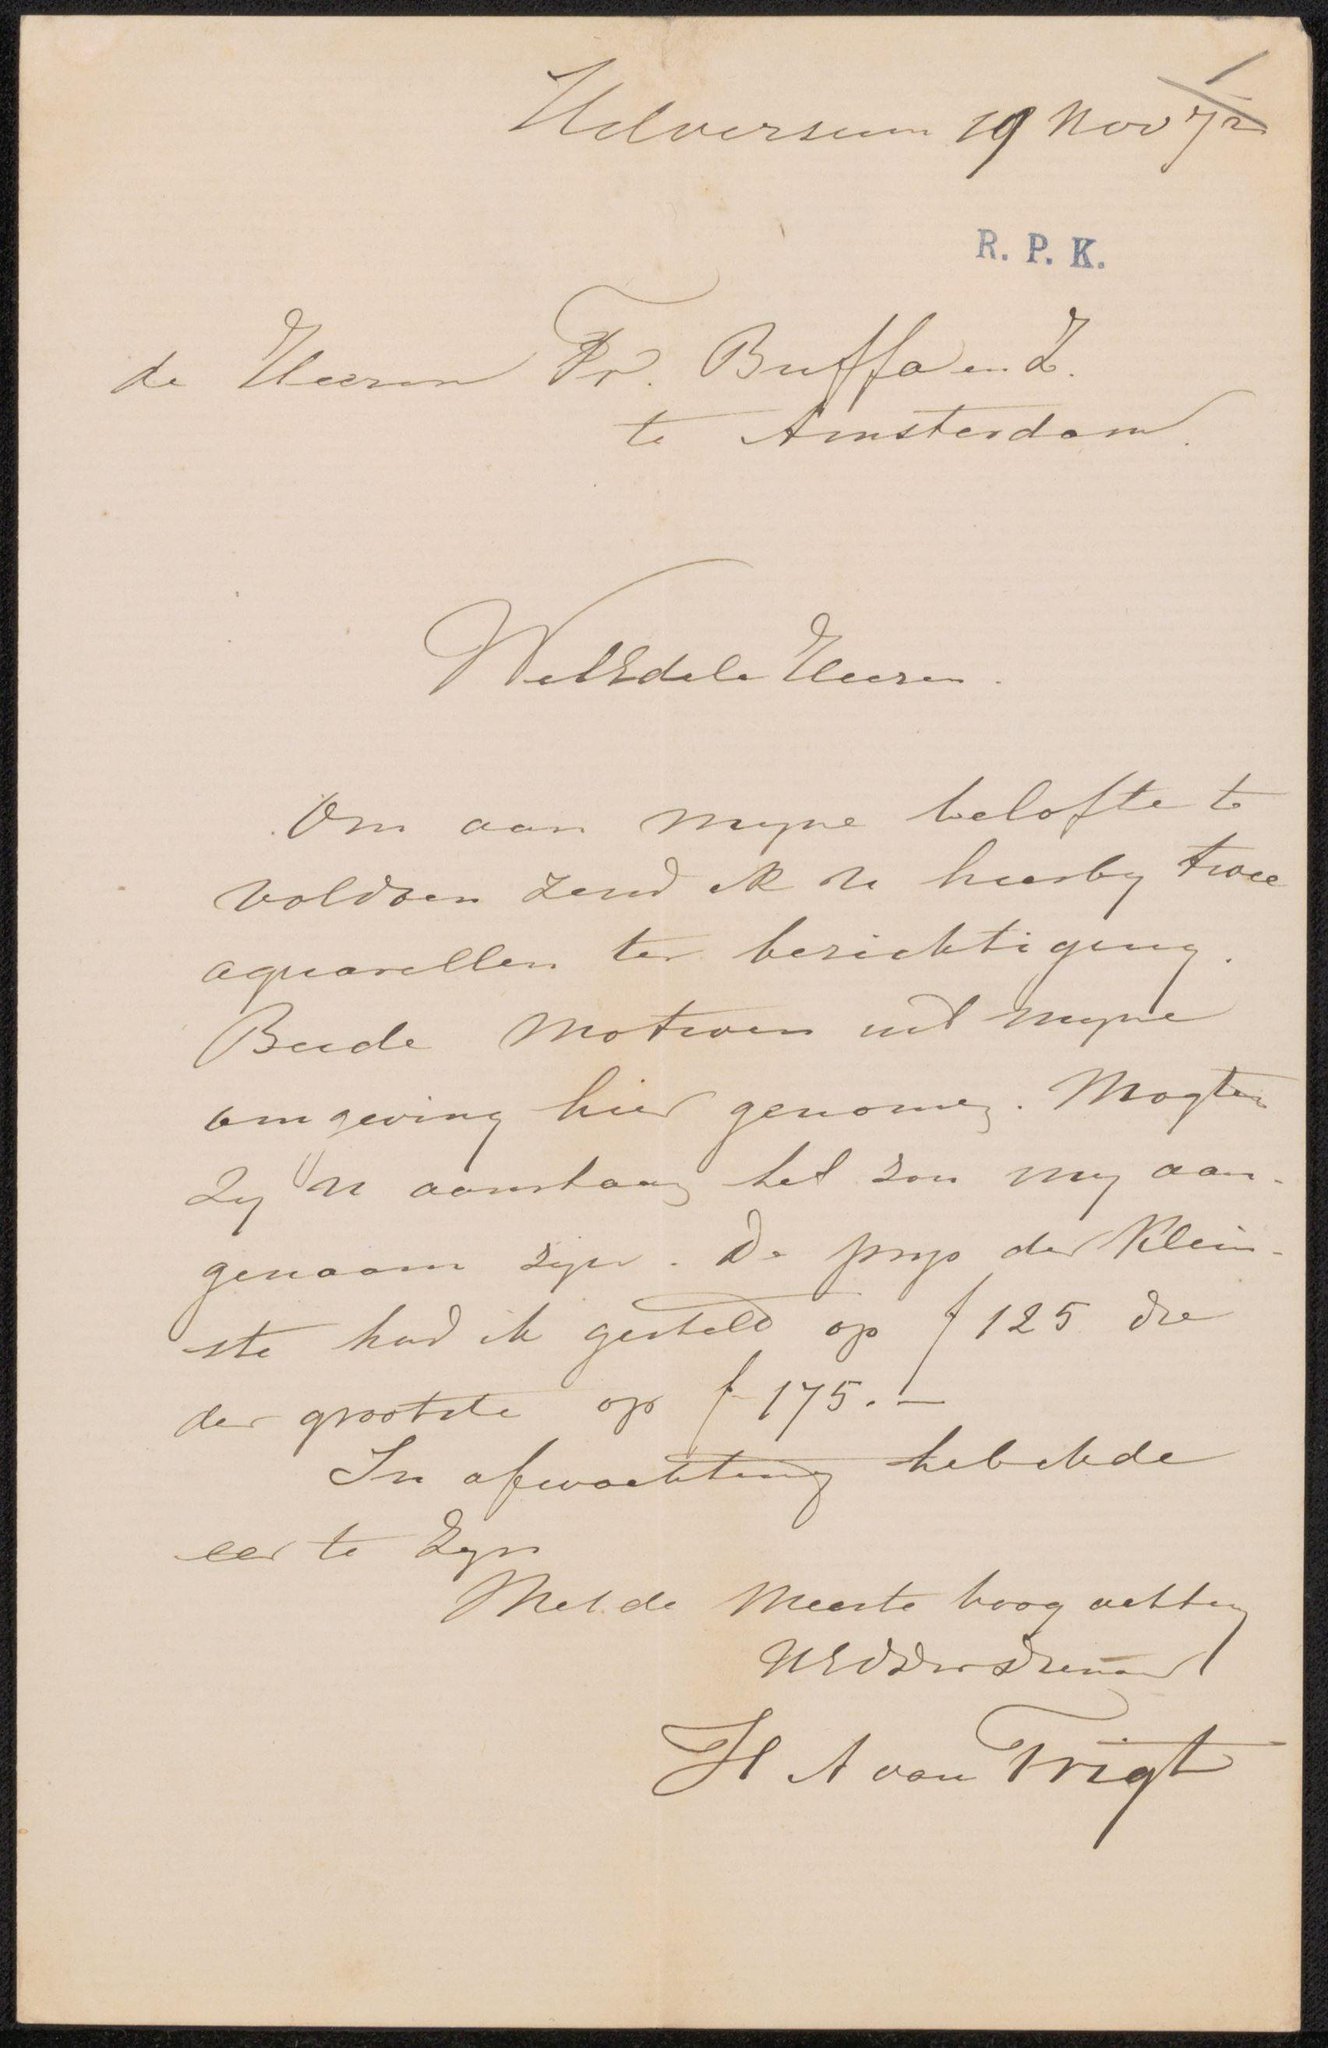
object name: letter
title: Brief aan Frans Buffa en Zonen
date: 1872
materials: ink, paper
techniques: pen, writing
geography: hilversum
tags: publisher, art trade, art shop, drawing, money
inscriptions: collector's mark: Lugt 2233